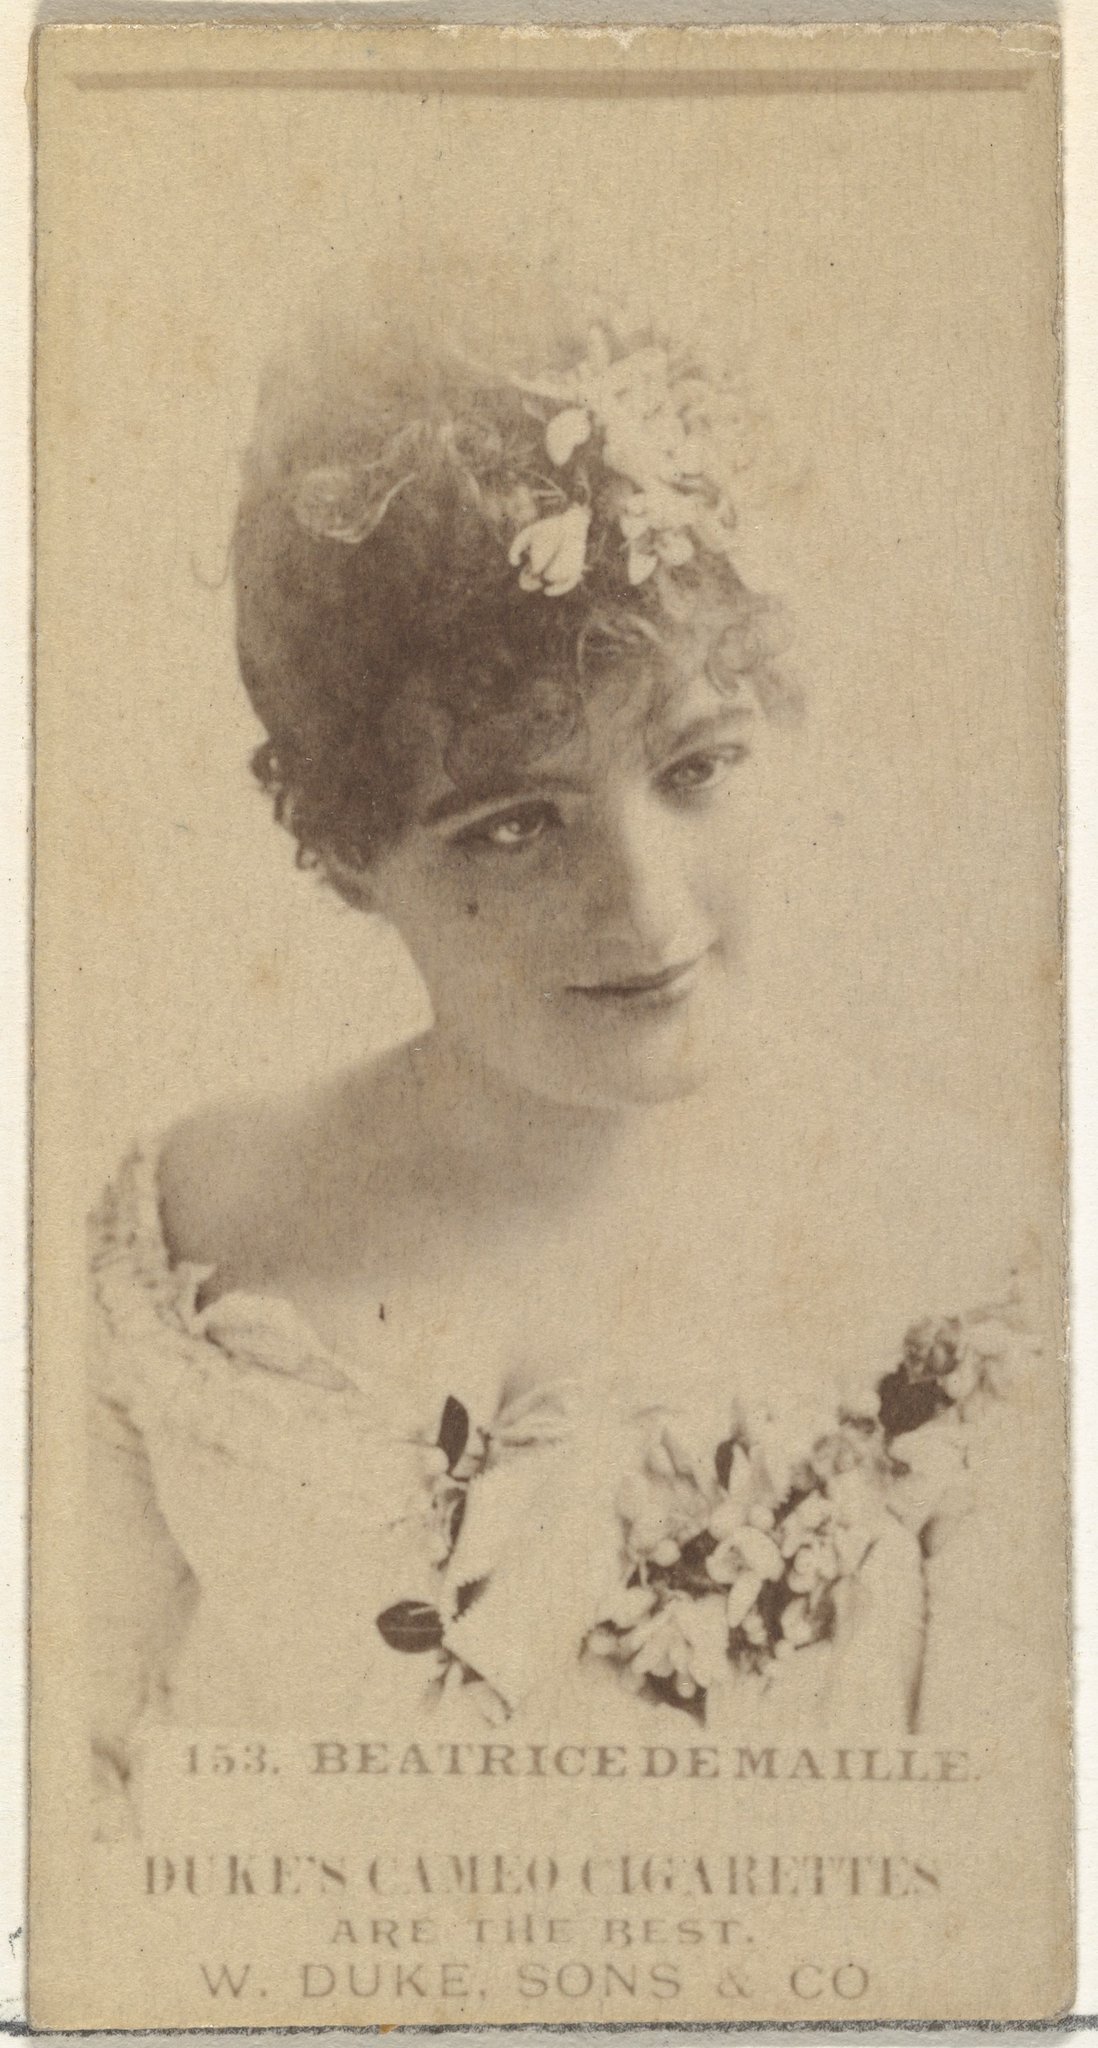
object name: photograph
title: Card Number 153, Beatrice De Maille, from the Actors and Actresses series (N145-5) issued by Duke Sons & Co. to promote Cameo Cigarettes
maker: w. duke, sons & co.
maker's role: publisher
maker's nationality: american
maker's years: 1870-1920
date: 1880-1889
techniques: albumen silver print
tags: portraits,women,actresses